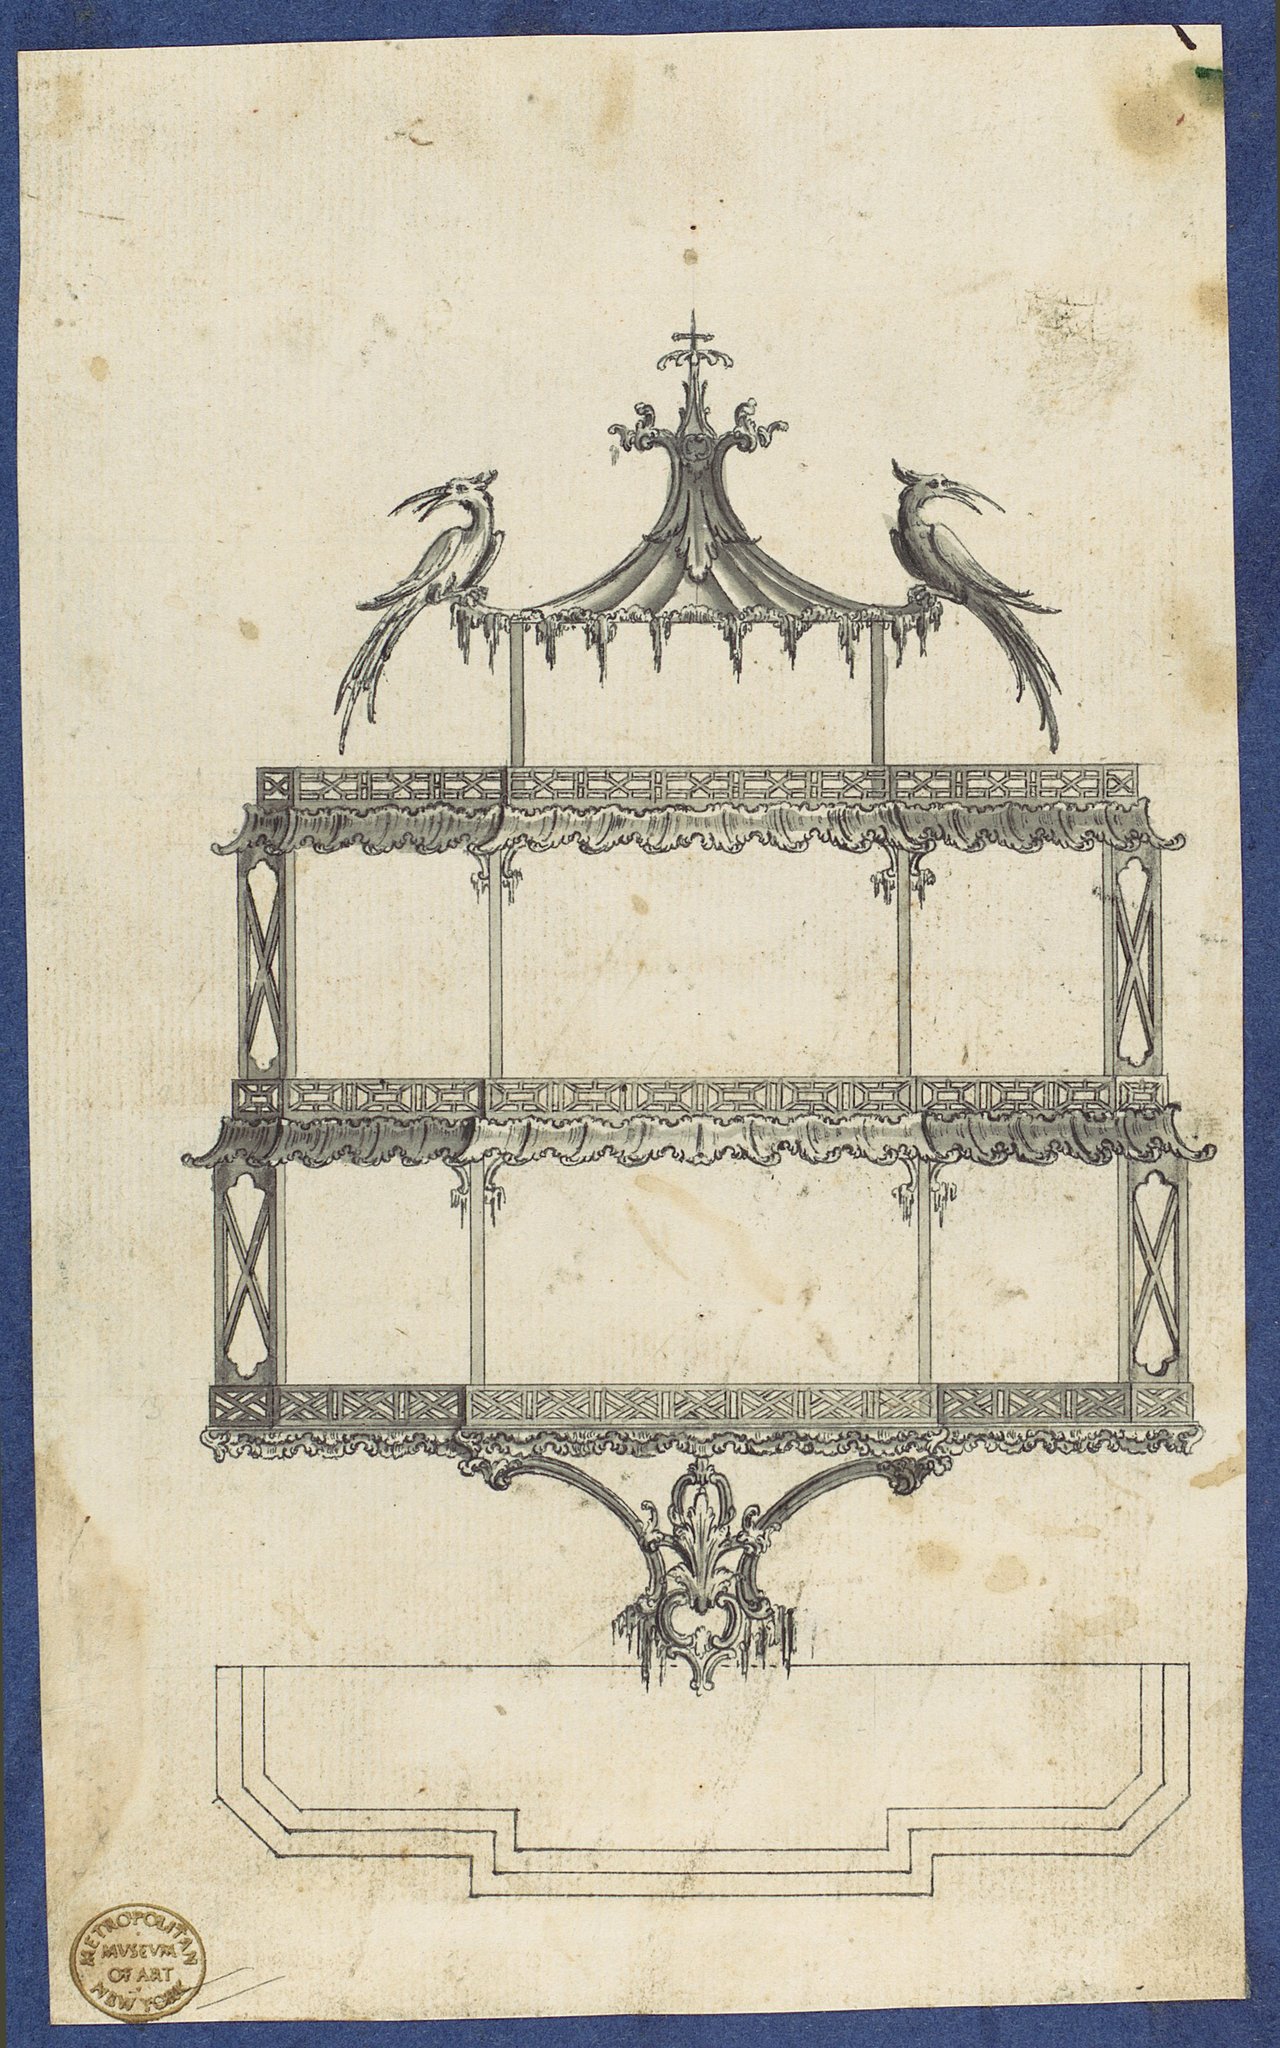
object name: drawing ornament architecture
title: Hanging Shelves, from Chippendale Drawings, Vol. II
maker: thomas chippendale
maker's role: artist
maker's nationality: british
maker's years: 1718-1779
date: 1754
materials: ink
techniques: wash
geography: london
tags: birds,furniture